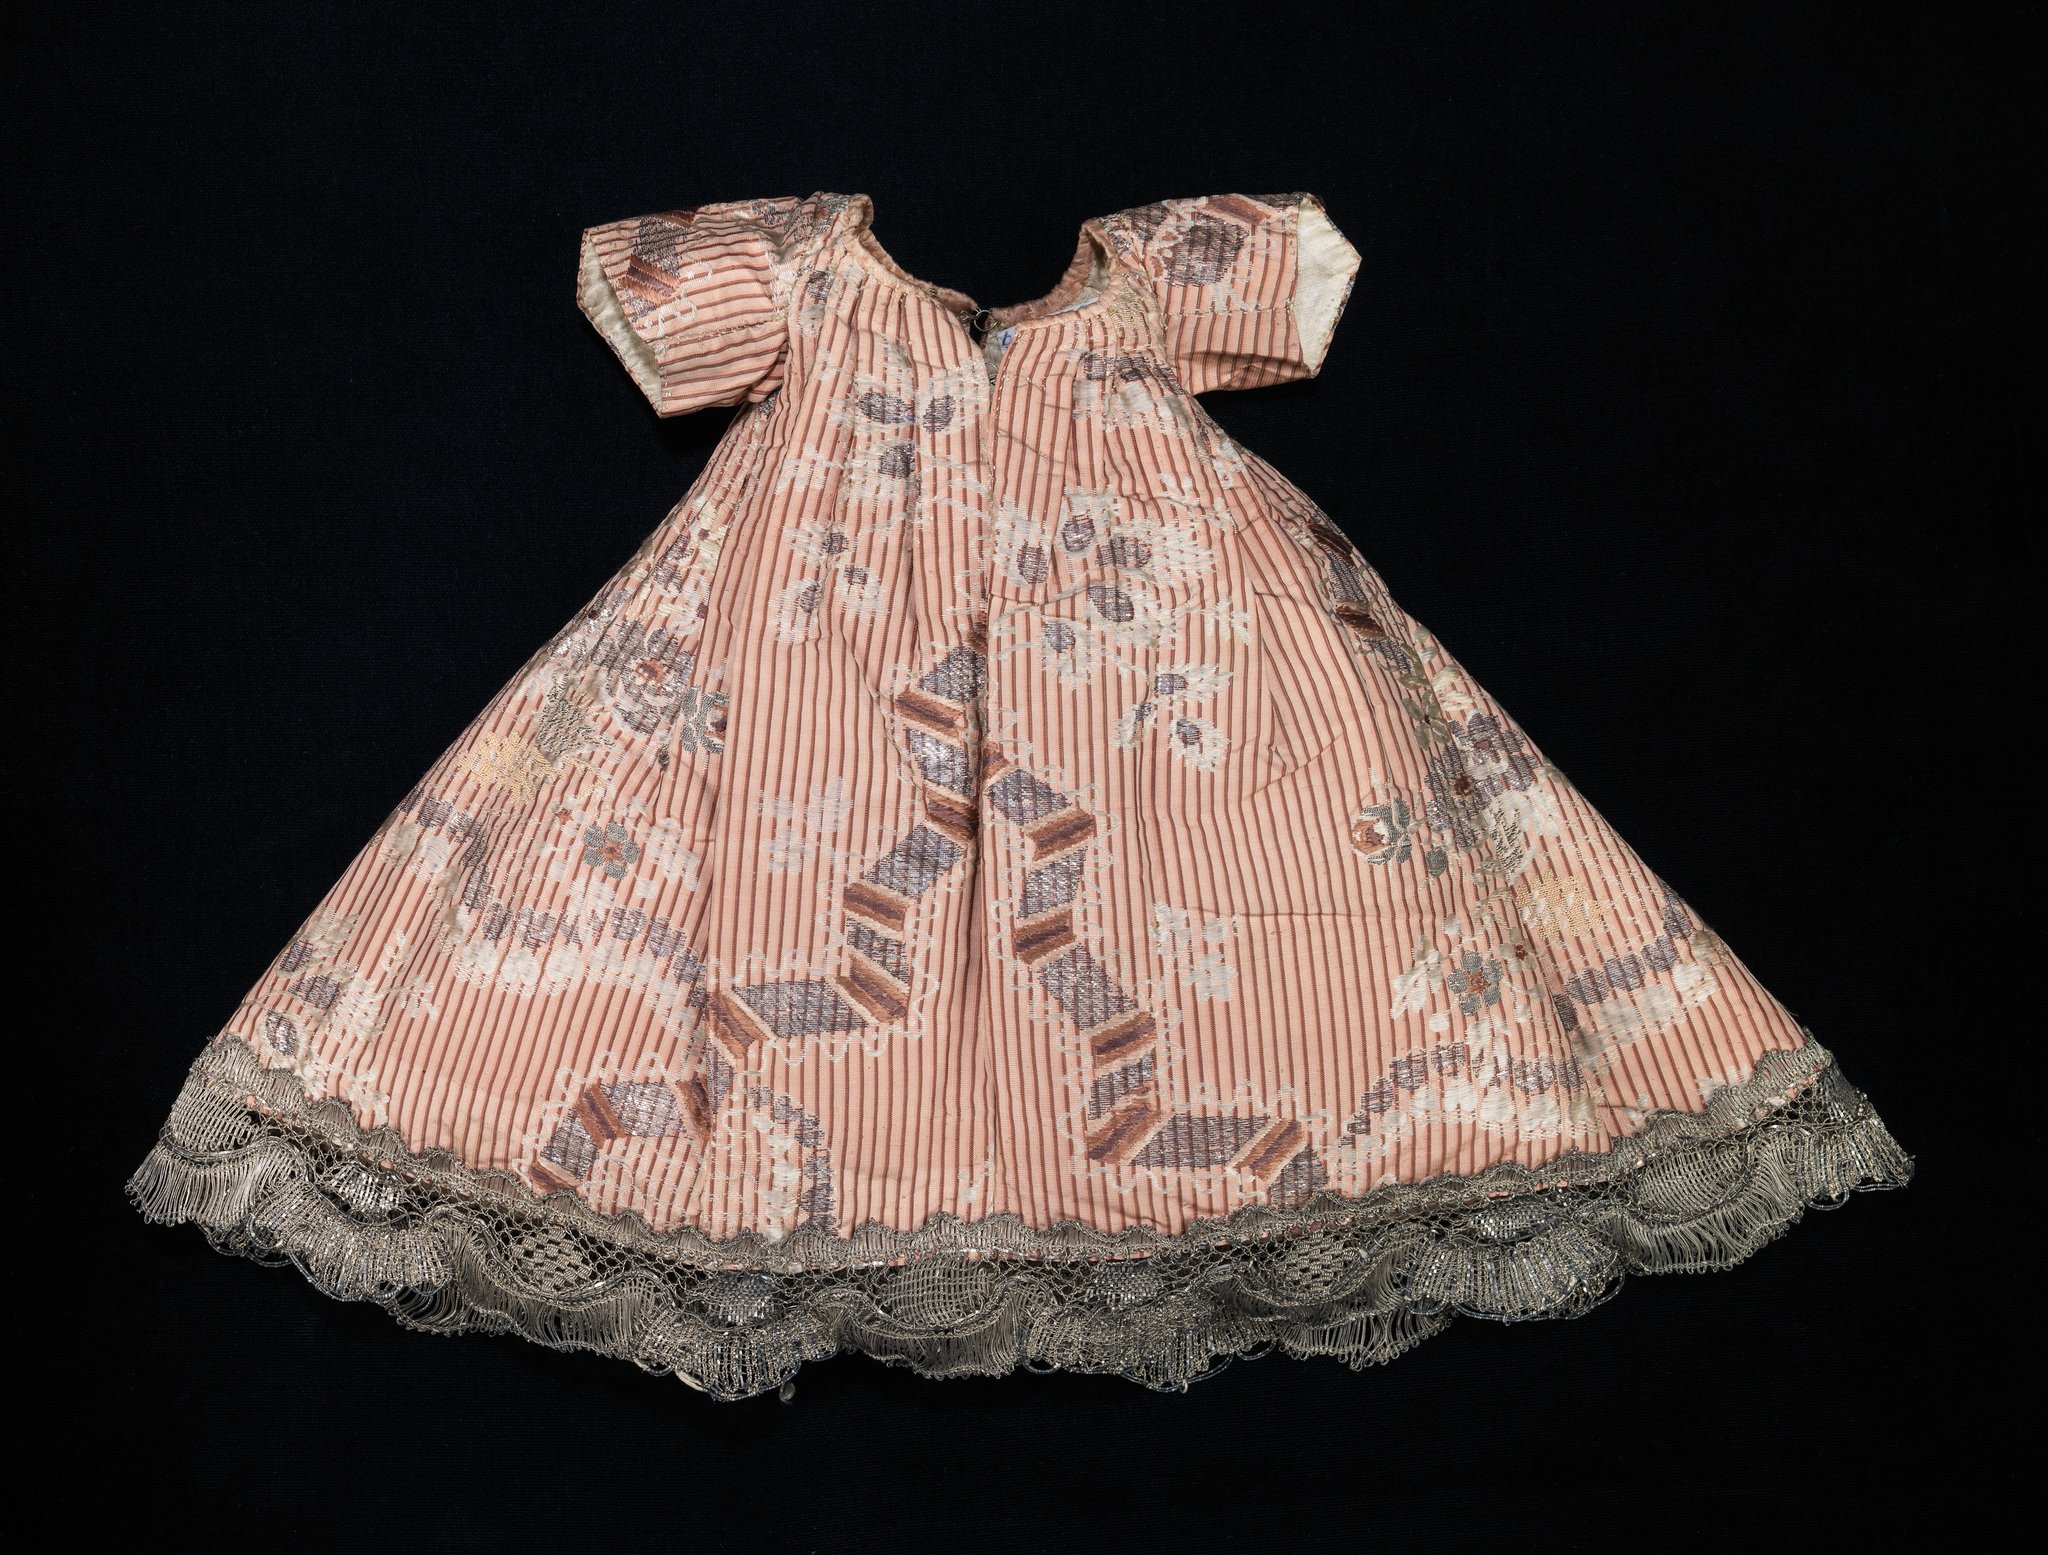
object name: dress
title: Dress for an altar figure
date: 1751-1775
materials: metal, silk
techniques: lace